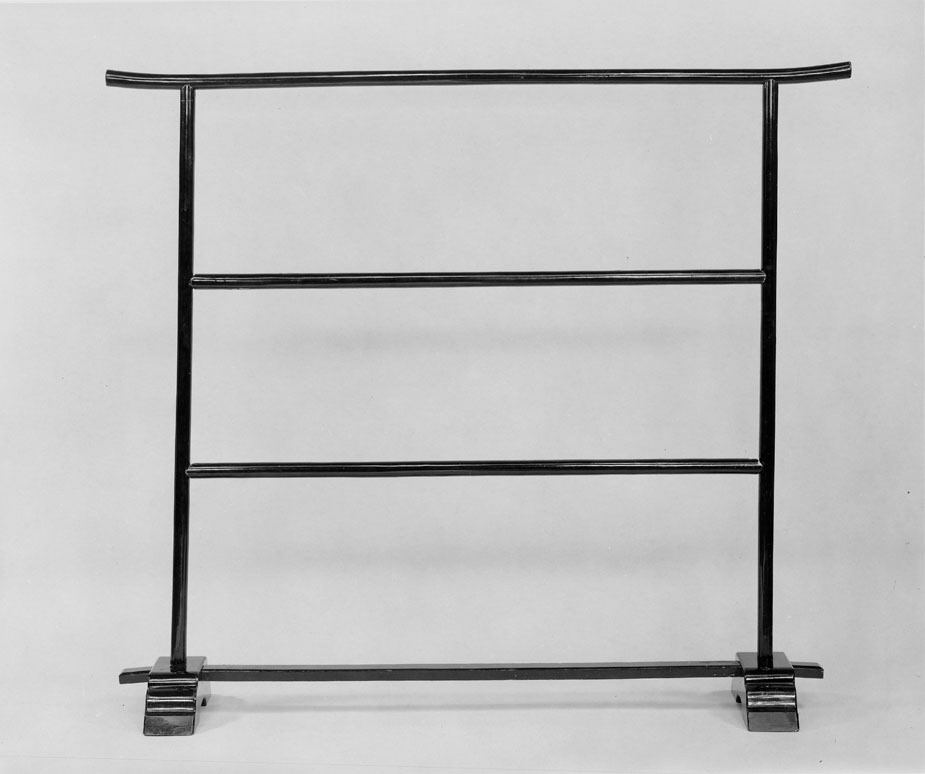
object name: robe stand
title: Kimono rack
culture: japanese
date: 1801-1900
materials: wood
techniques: lacquer